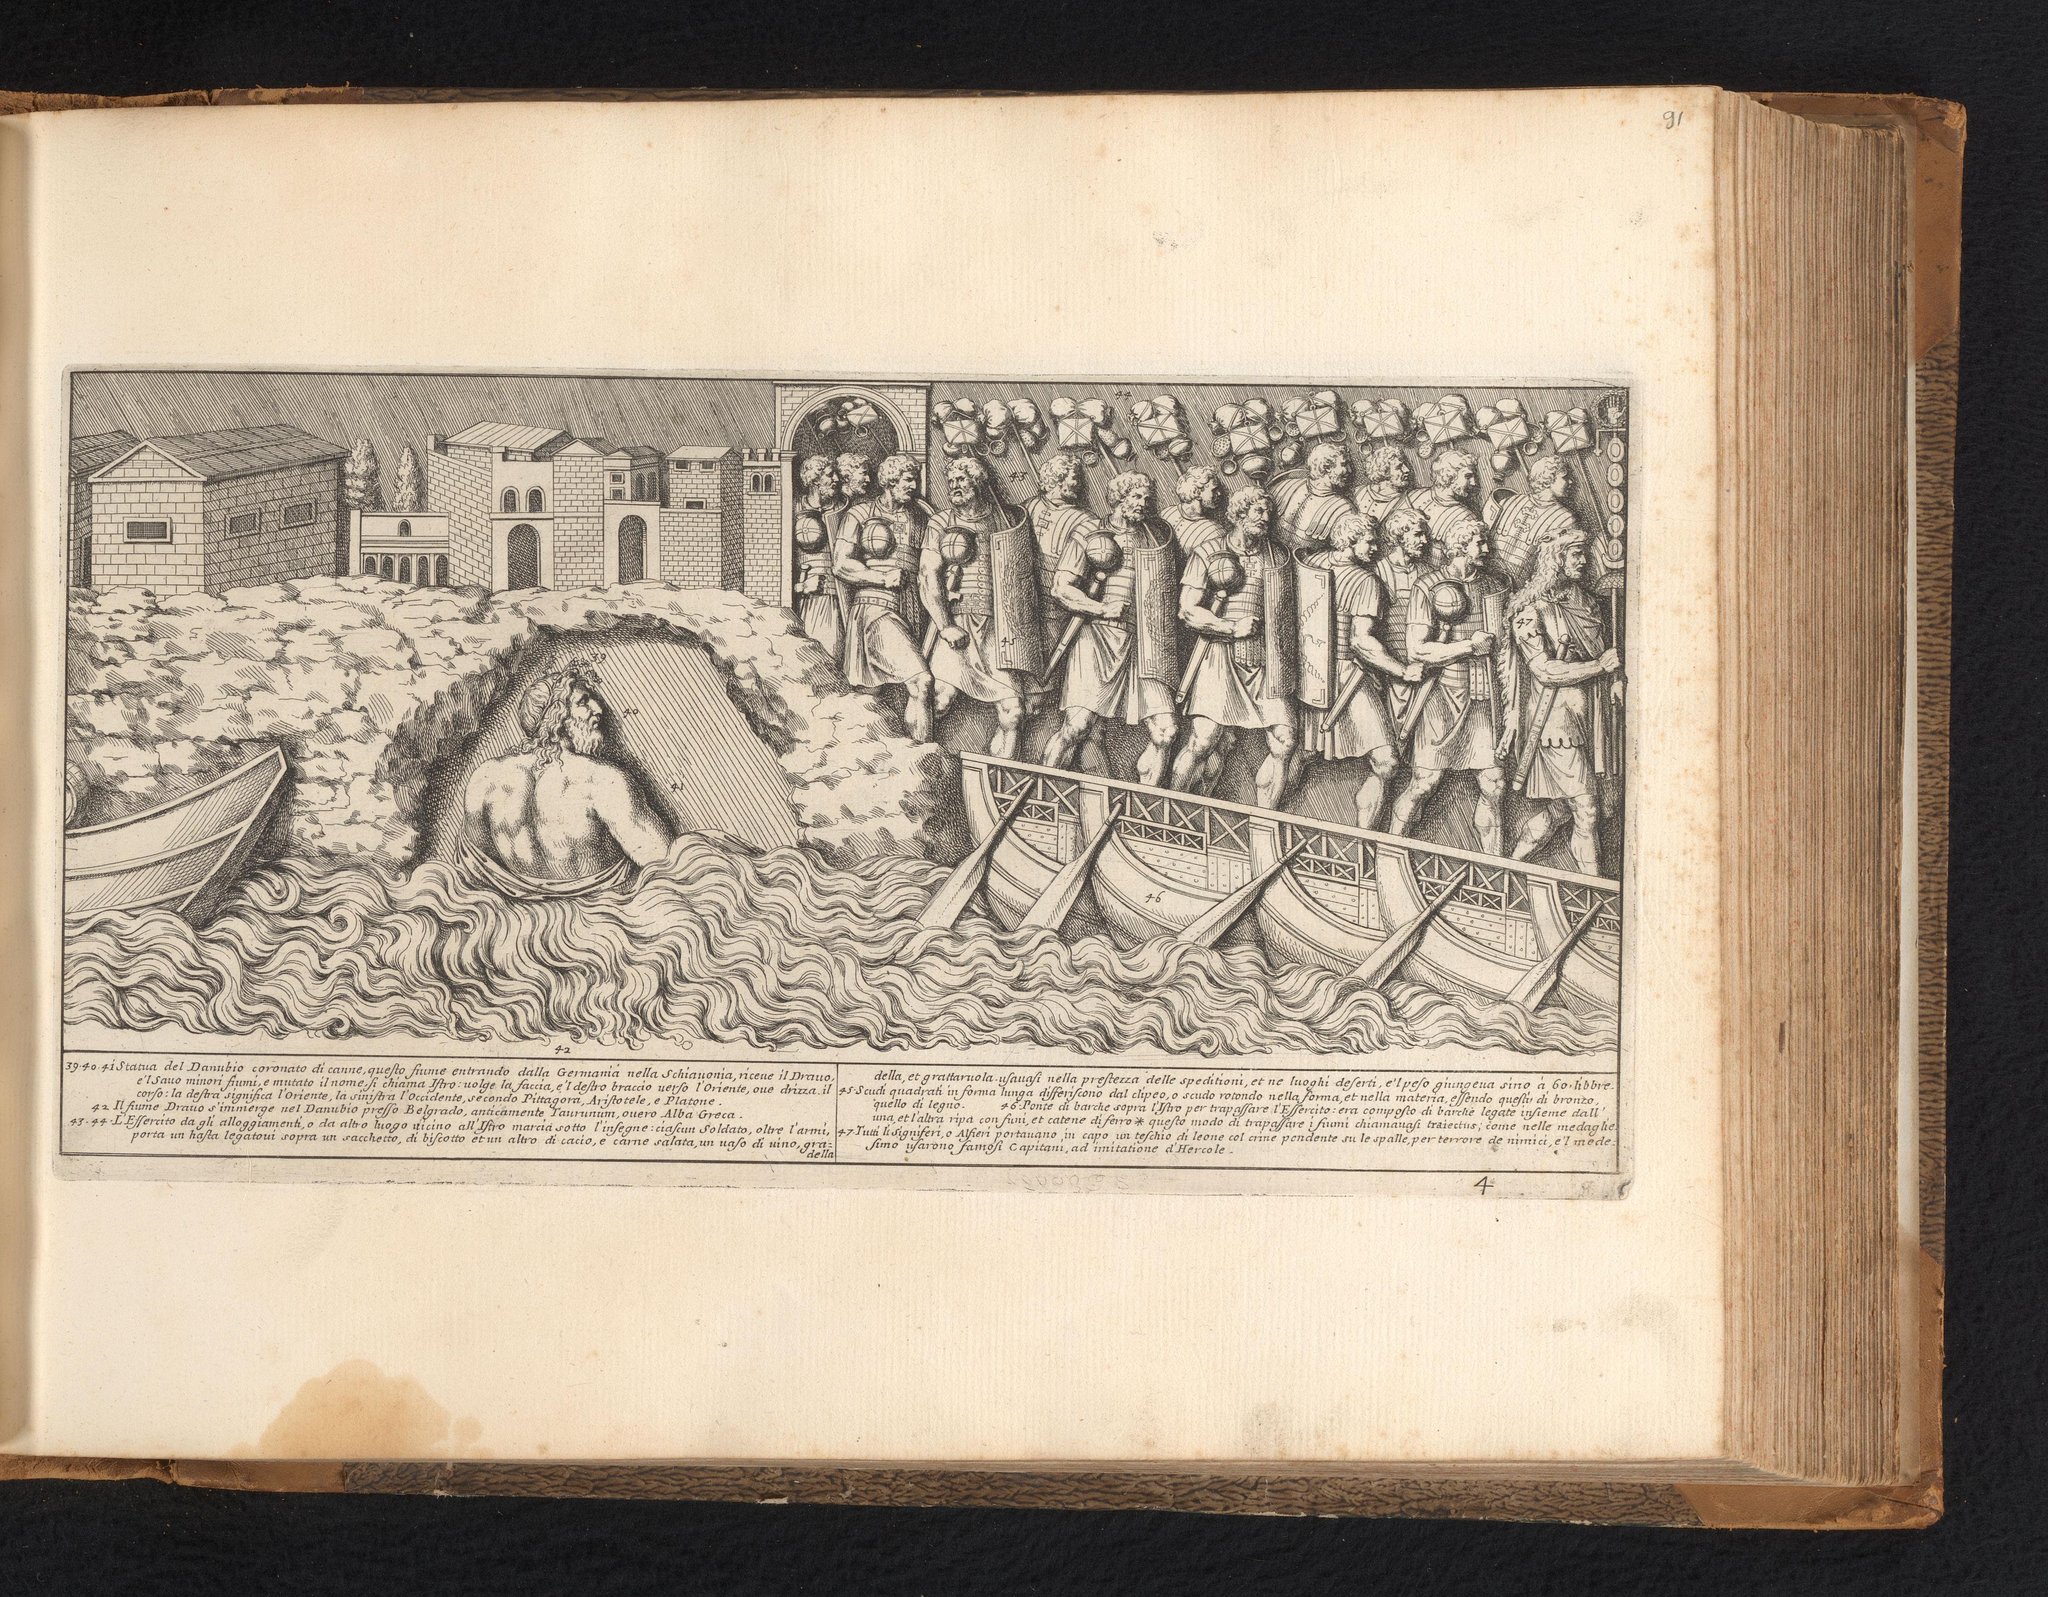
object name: album leaf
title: Zuil van Trajanus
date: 1637-1691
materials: paper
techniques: etching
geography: rome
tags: triumphal column with helical friezes, piece of sculpture, reproduction of a piece of sculpture, the soldier; the soldier's life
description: Detail van het spiraalvormige gebeeldhouwde fries op de Zuil van Trajanus. Het fries toont de oorlogen tussen de Romeinen en de Daciërs. Verklarende nummers in de ondermarge. Prent maakt deel uit van een album.